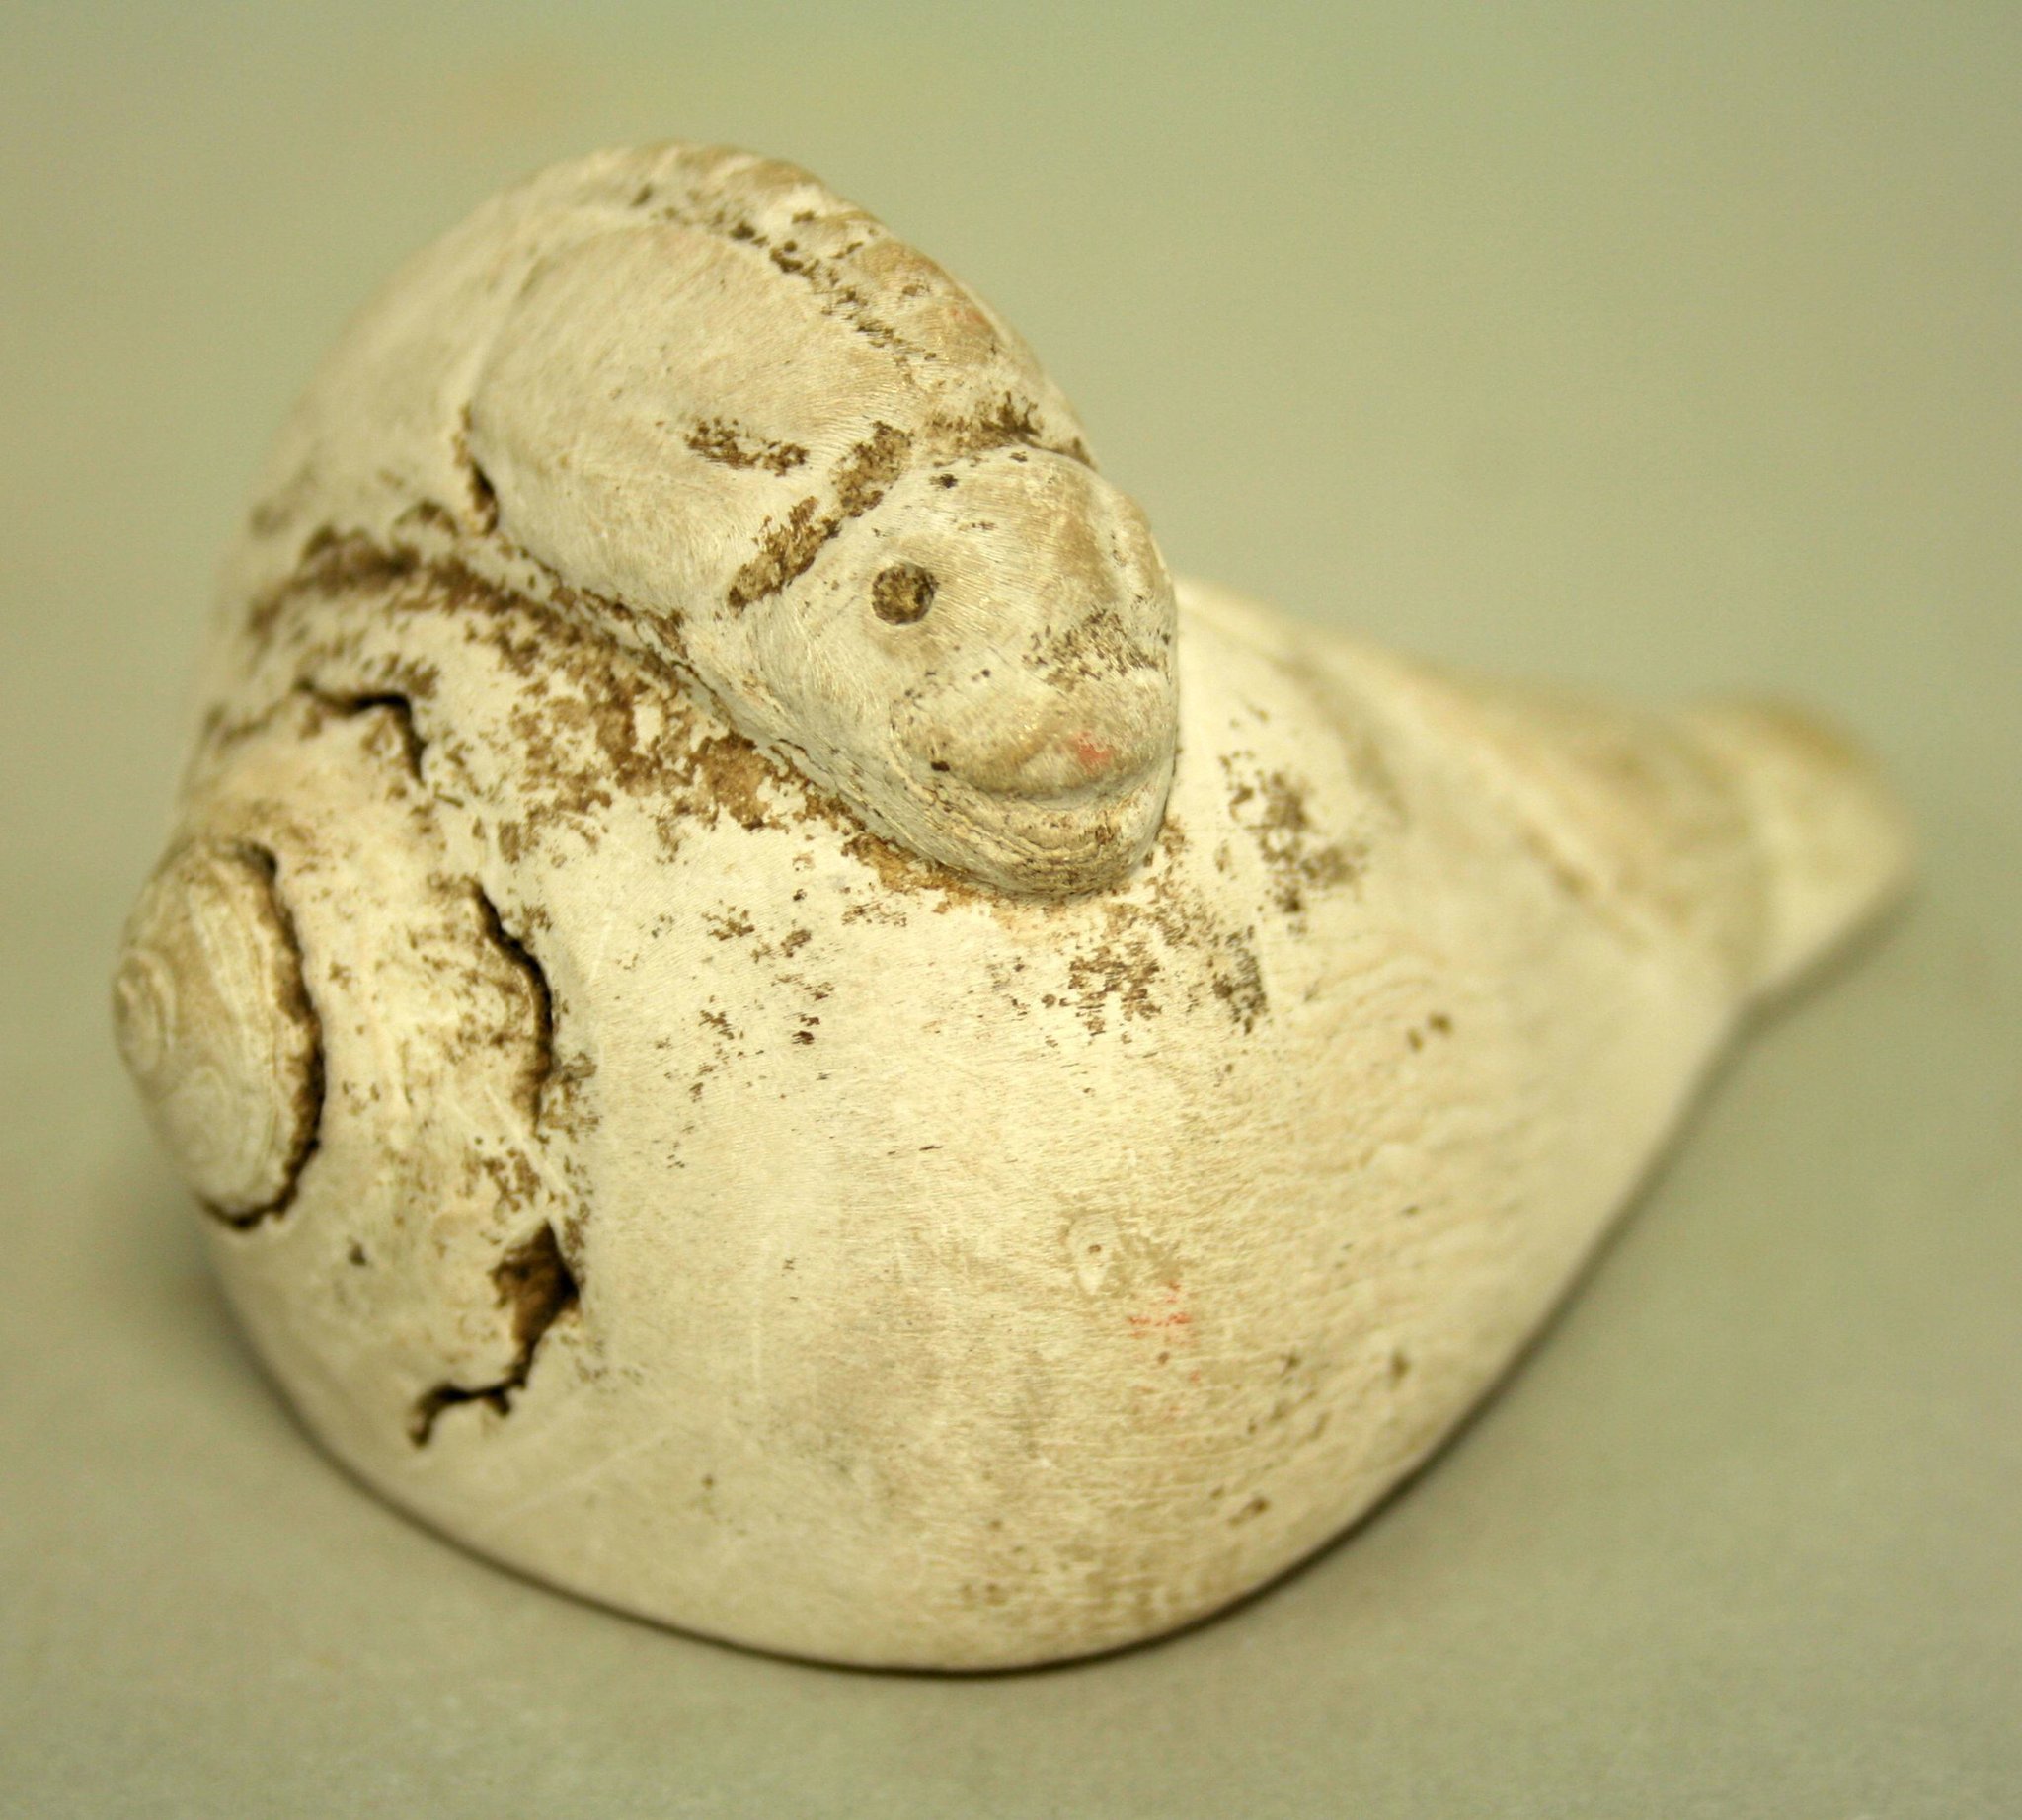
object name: lime container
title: Shell Lime Container in the Shape of a Lizard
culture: bahia or chorrera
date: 200 BCE-300 CE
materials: shell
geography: ecuador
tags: lizards